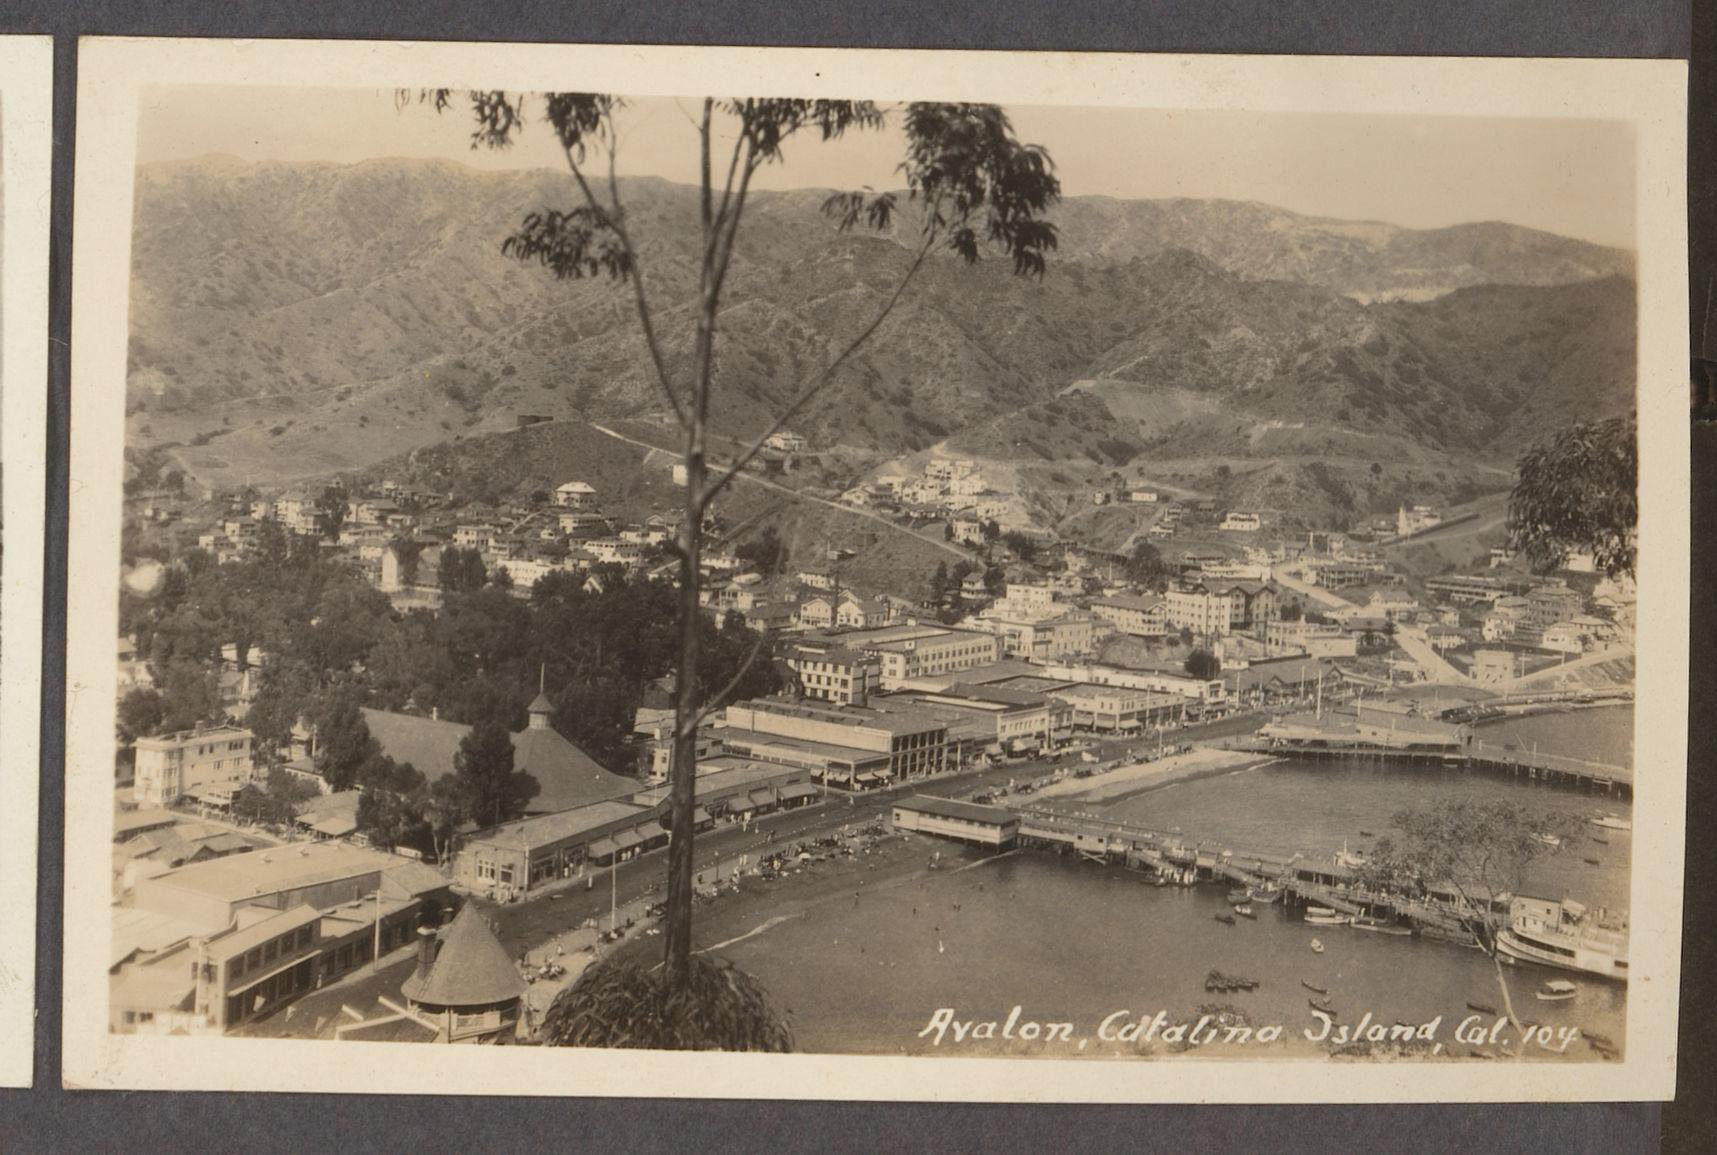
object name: photograph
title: Gezicht op Avalon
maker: Anonymous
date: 1928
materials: photographic support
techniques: gelatin silver print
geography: santa catalina island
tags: gulf, bay, city-view, and landscape with man-made constructions, (high) hill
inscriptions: inscription: ‘Avalon, Catalina Island, Cal 104’, annotation: ‘Catalina eiland’